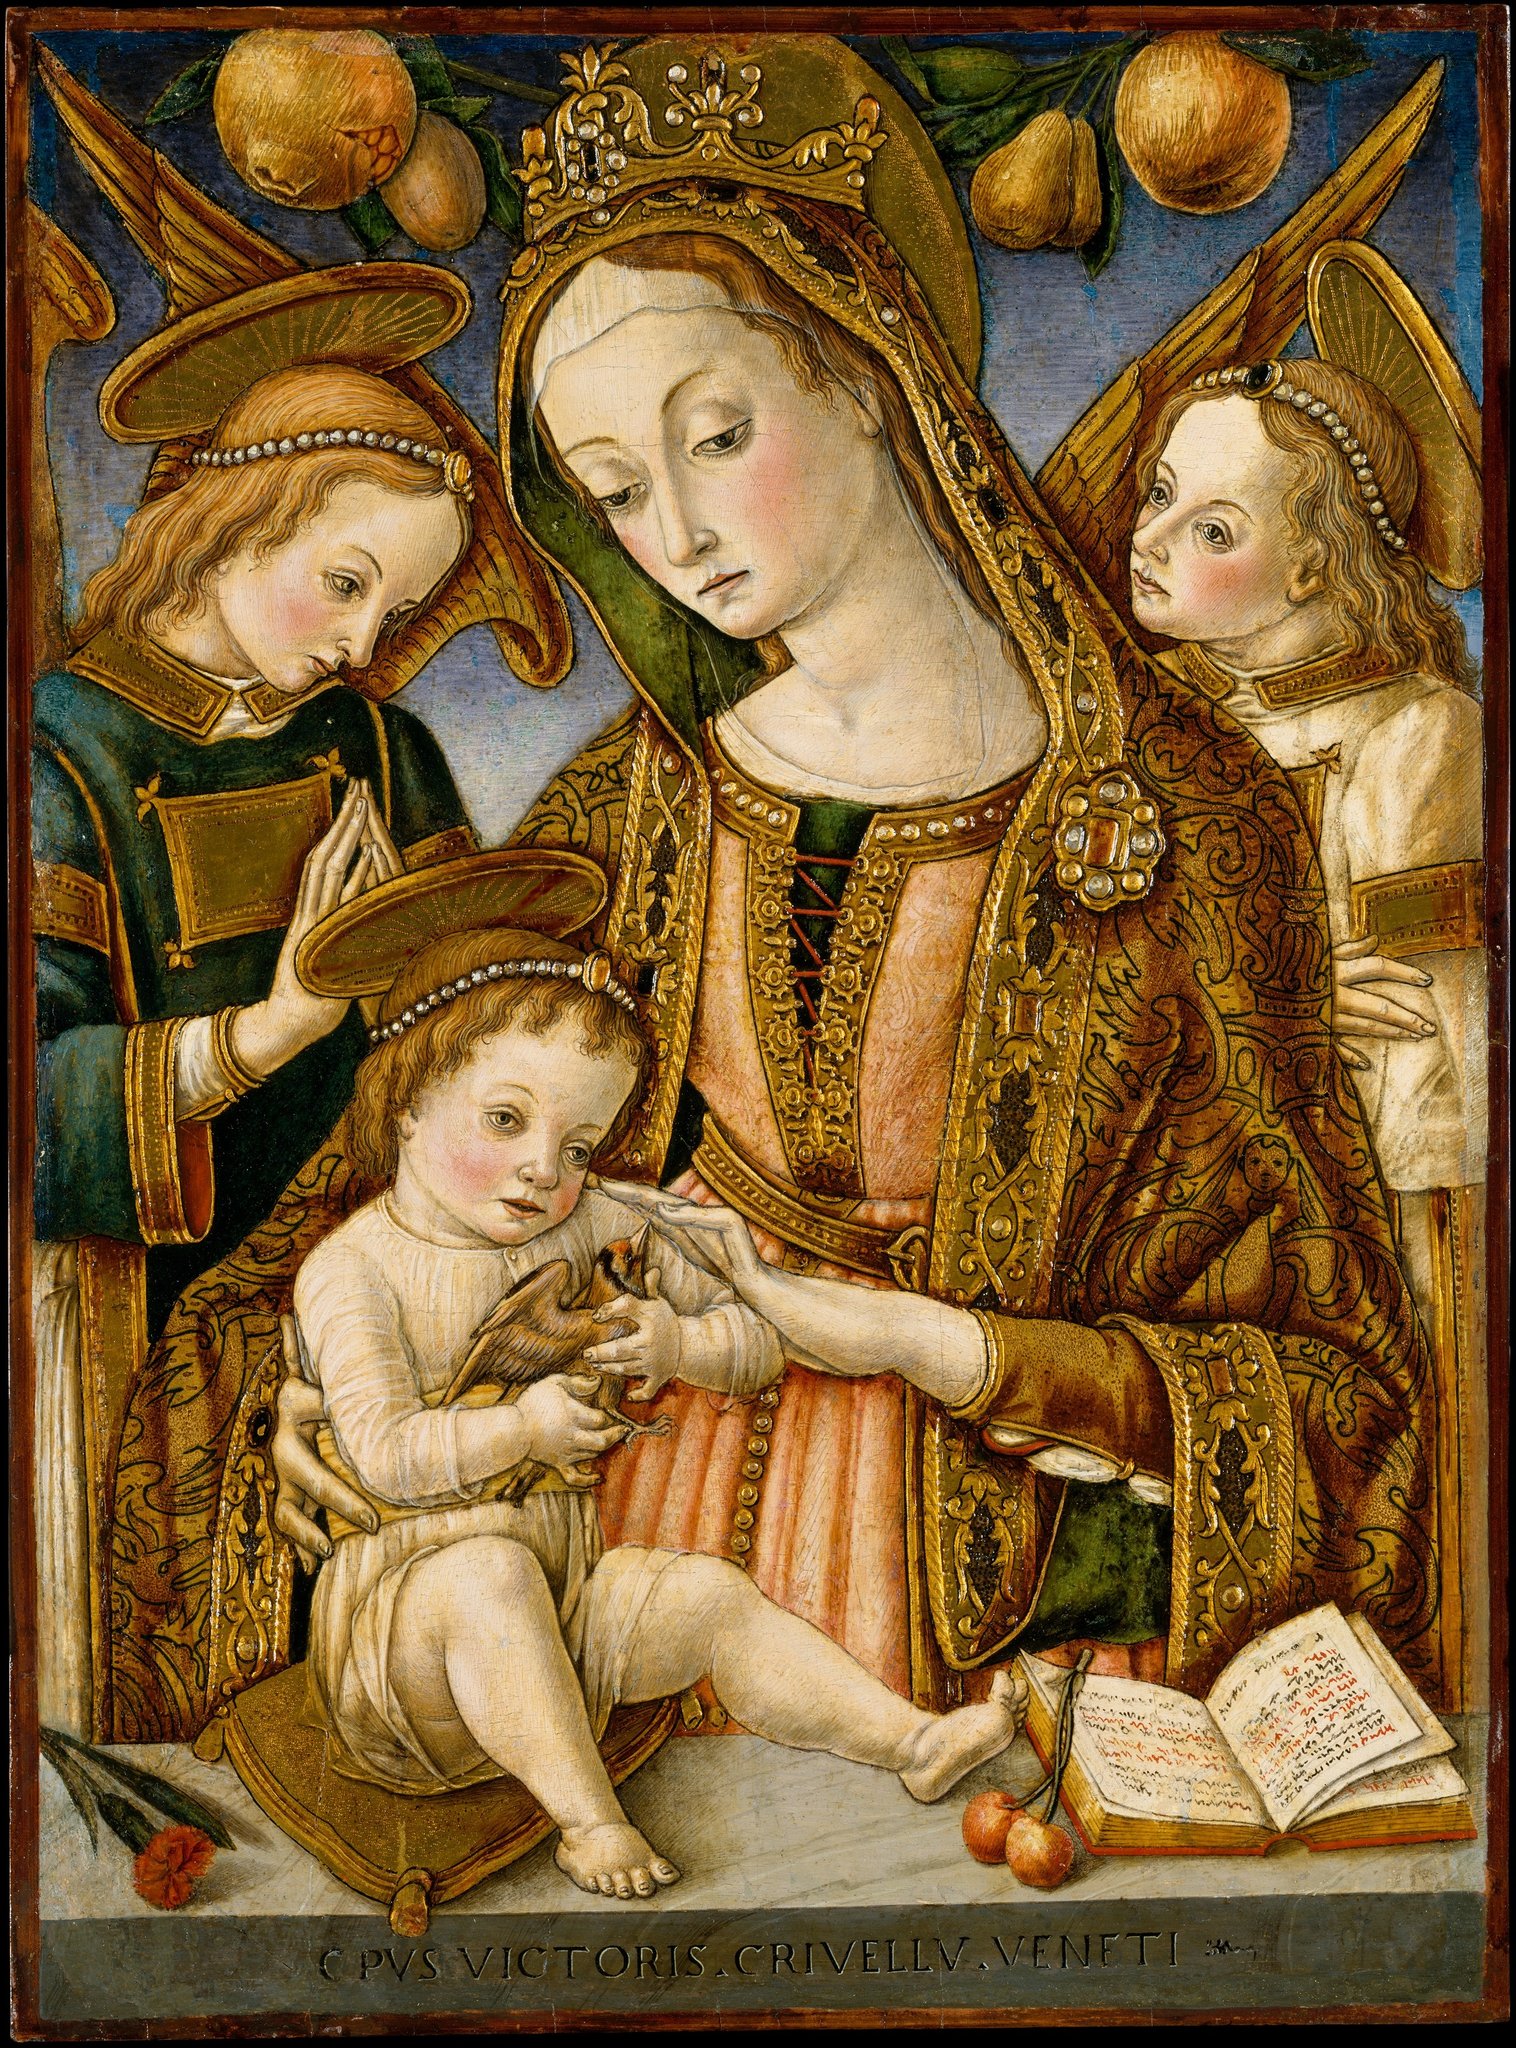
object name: painting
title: Madonna and Child with Two Angels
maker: vittore crivelli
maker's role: artist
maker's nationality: italian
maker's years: 1465-1502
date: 1481-1482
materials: gold, paint, wood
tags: birds,fruit,angels,madonna and child